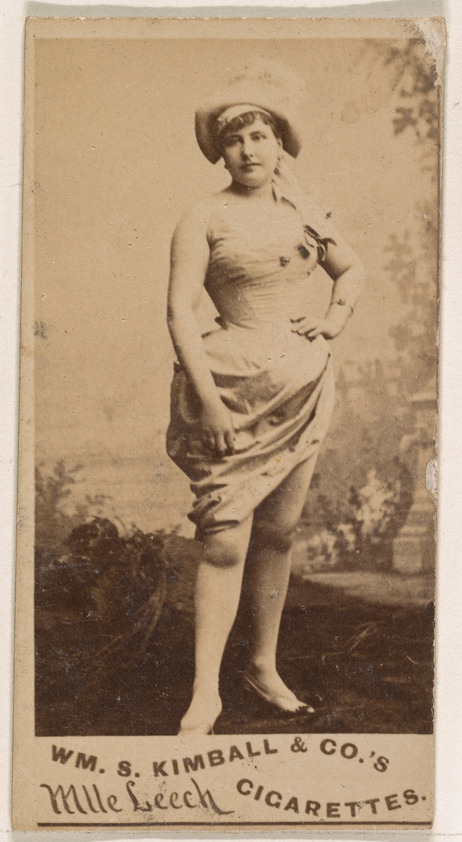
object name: photograph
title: Mlle. Leech, from the Actresses series (N203) issued by Wm. S. Kimball & Co.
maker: william s. kimball & company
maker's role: publisher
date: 1889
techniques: color lithograph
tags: portraits,women,actresses